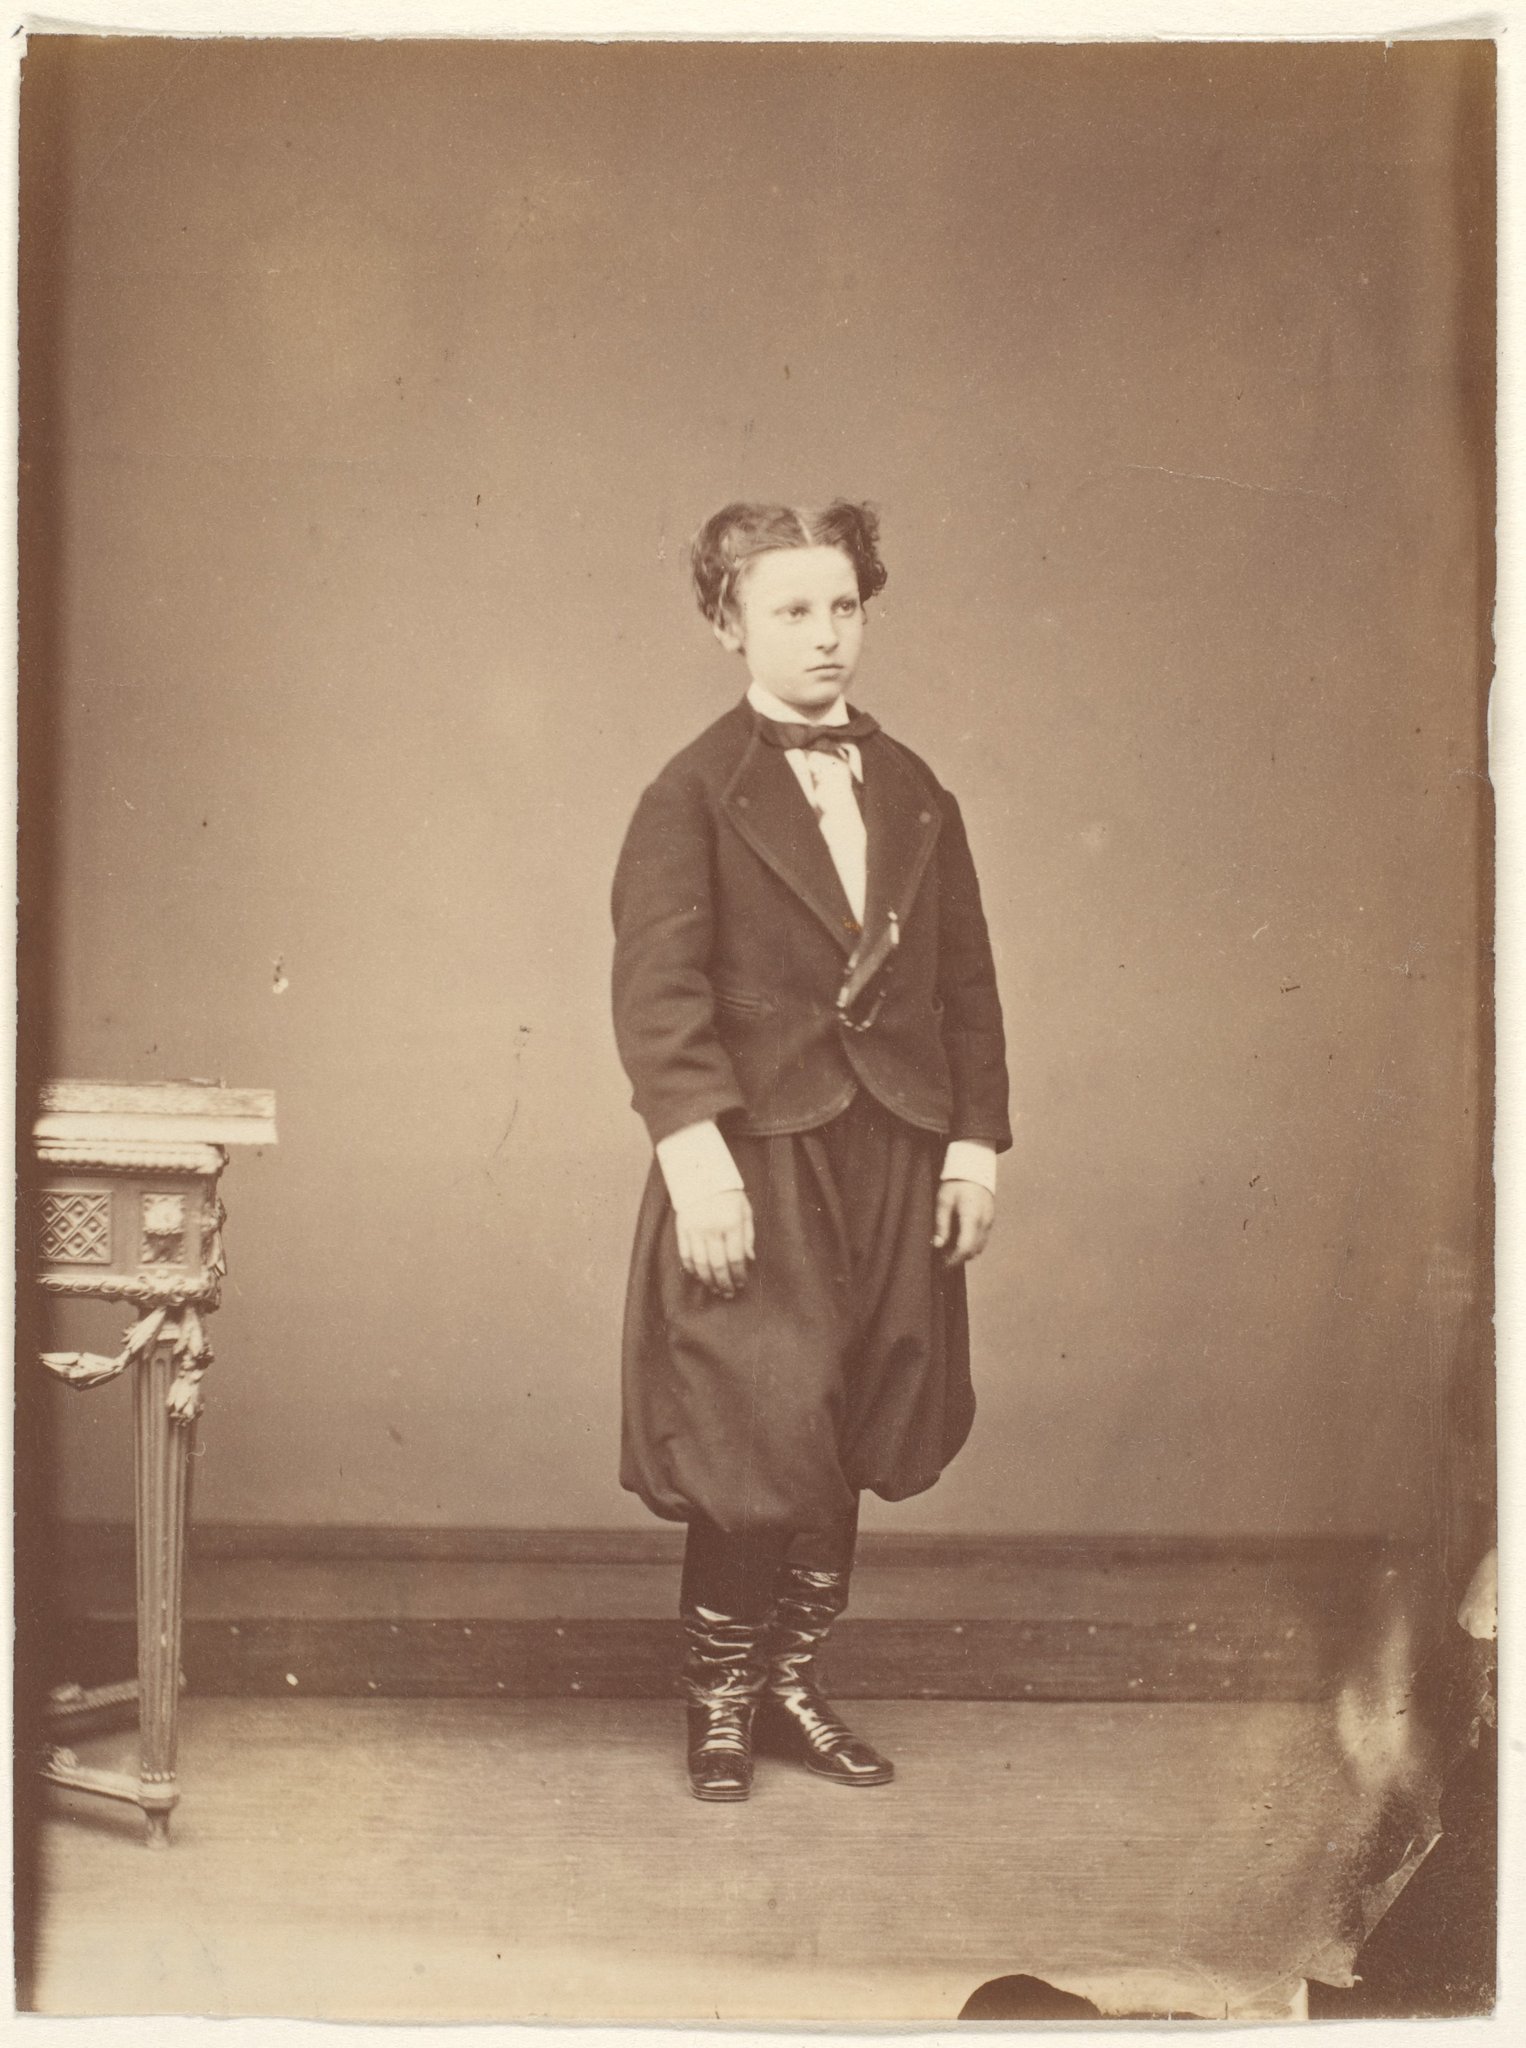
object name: photograph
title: Le petit Russe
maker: pierre-louis pierson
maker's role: artist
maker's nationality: french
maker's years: 1822-1913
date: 1860-1869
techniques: albumen silver print, glass negative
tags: boys,portraits